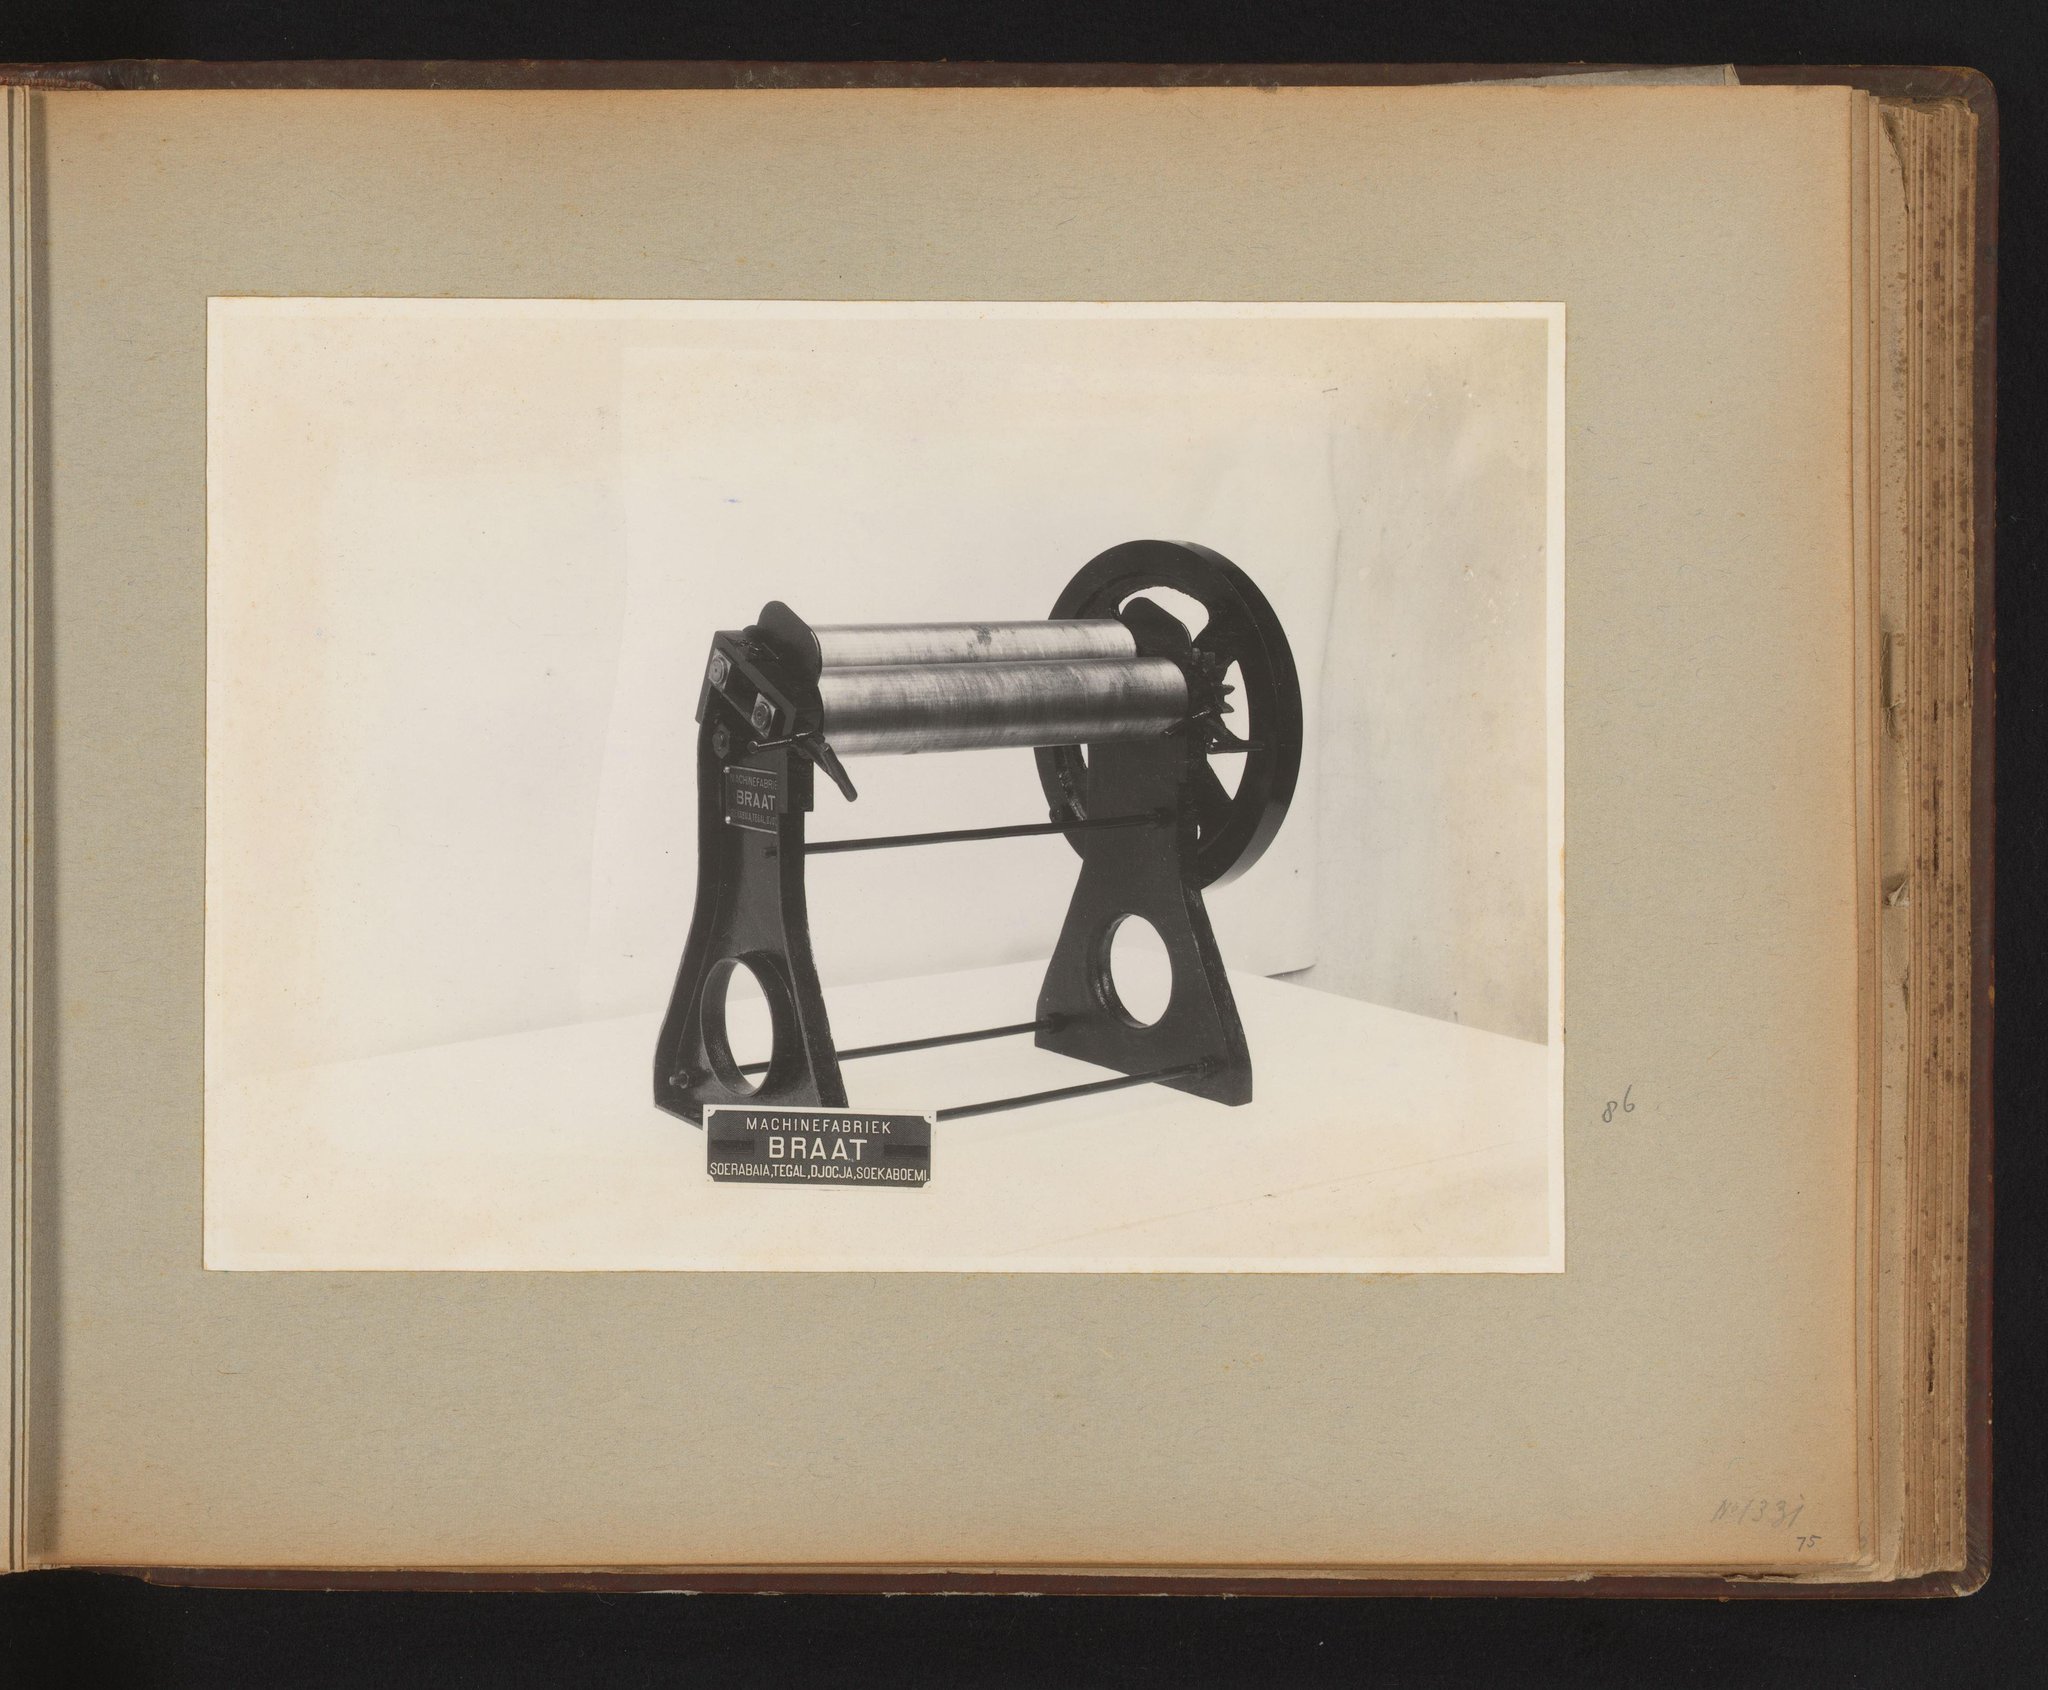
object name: photograph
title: Rollenpers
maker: Anonymous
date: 1931-1937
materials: cardboard, photographic support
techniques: gelatin silver print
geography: java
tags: pressing (industrial process), machines; parts of machines; tools and appliances, java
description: Albumblad met een foto van een soort rollenpers. Onderdeel van een fotoalbum met foto's van machines en constructies van de N.V. Machinefabriek Braat te Soerabaja, Soekaboemi en Tegal uit de periode 1931-1937.